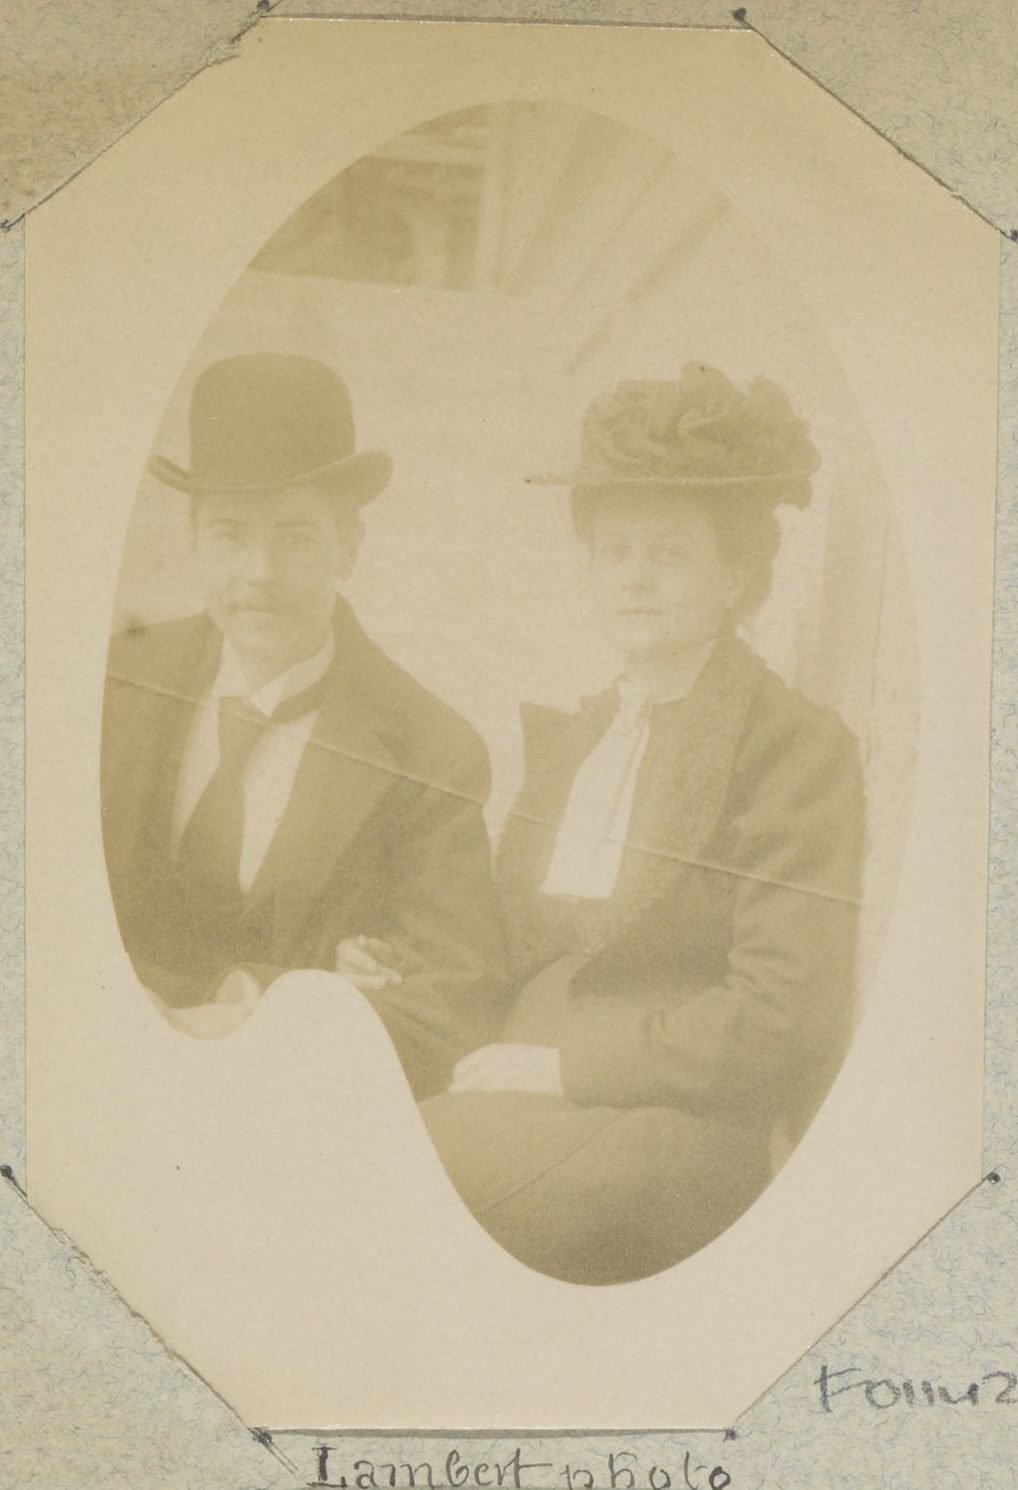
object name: photograph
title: Portret van een man en een vrouw met hoeden, vermoedelijk in Frankrijk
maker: lambert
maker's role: painter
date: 1890-1900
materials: paper, photographic support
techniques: albumen print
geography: france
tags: marriage, married couple, 'matrimonium', head-gear: hat, france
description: Onderdeel van Album van een Franse amateur met foto's van Frankrijk, Algerije, Palmyra, de Wereldtentoonstelling van 1900 en van bekende Fransen.